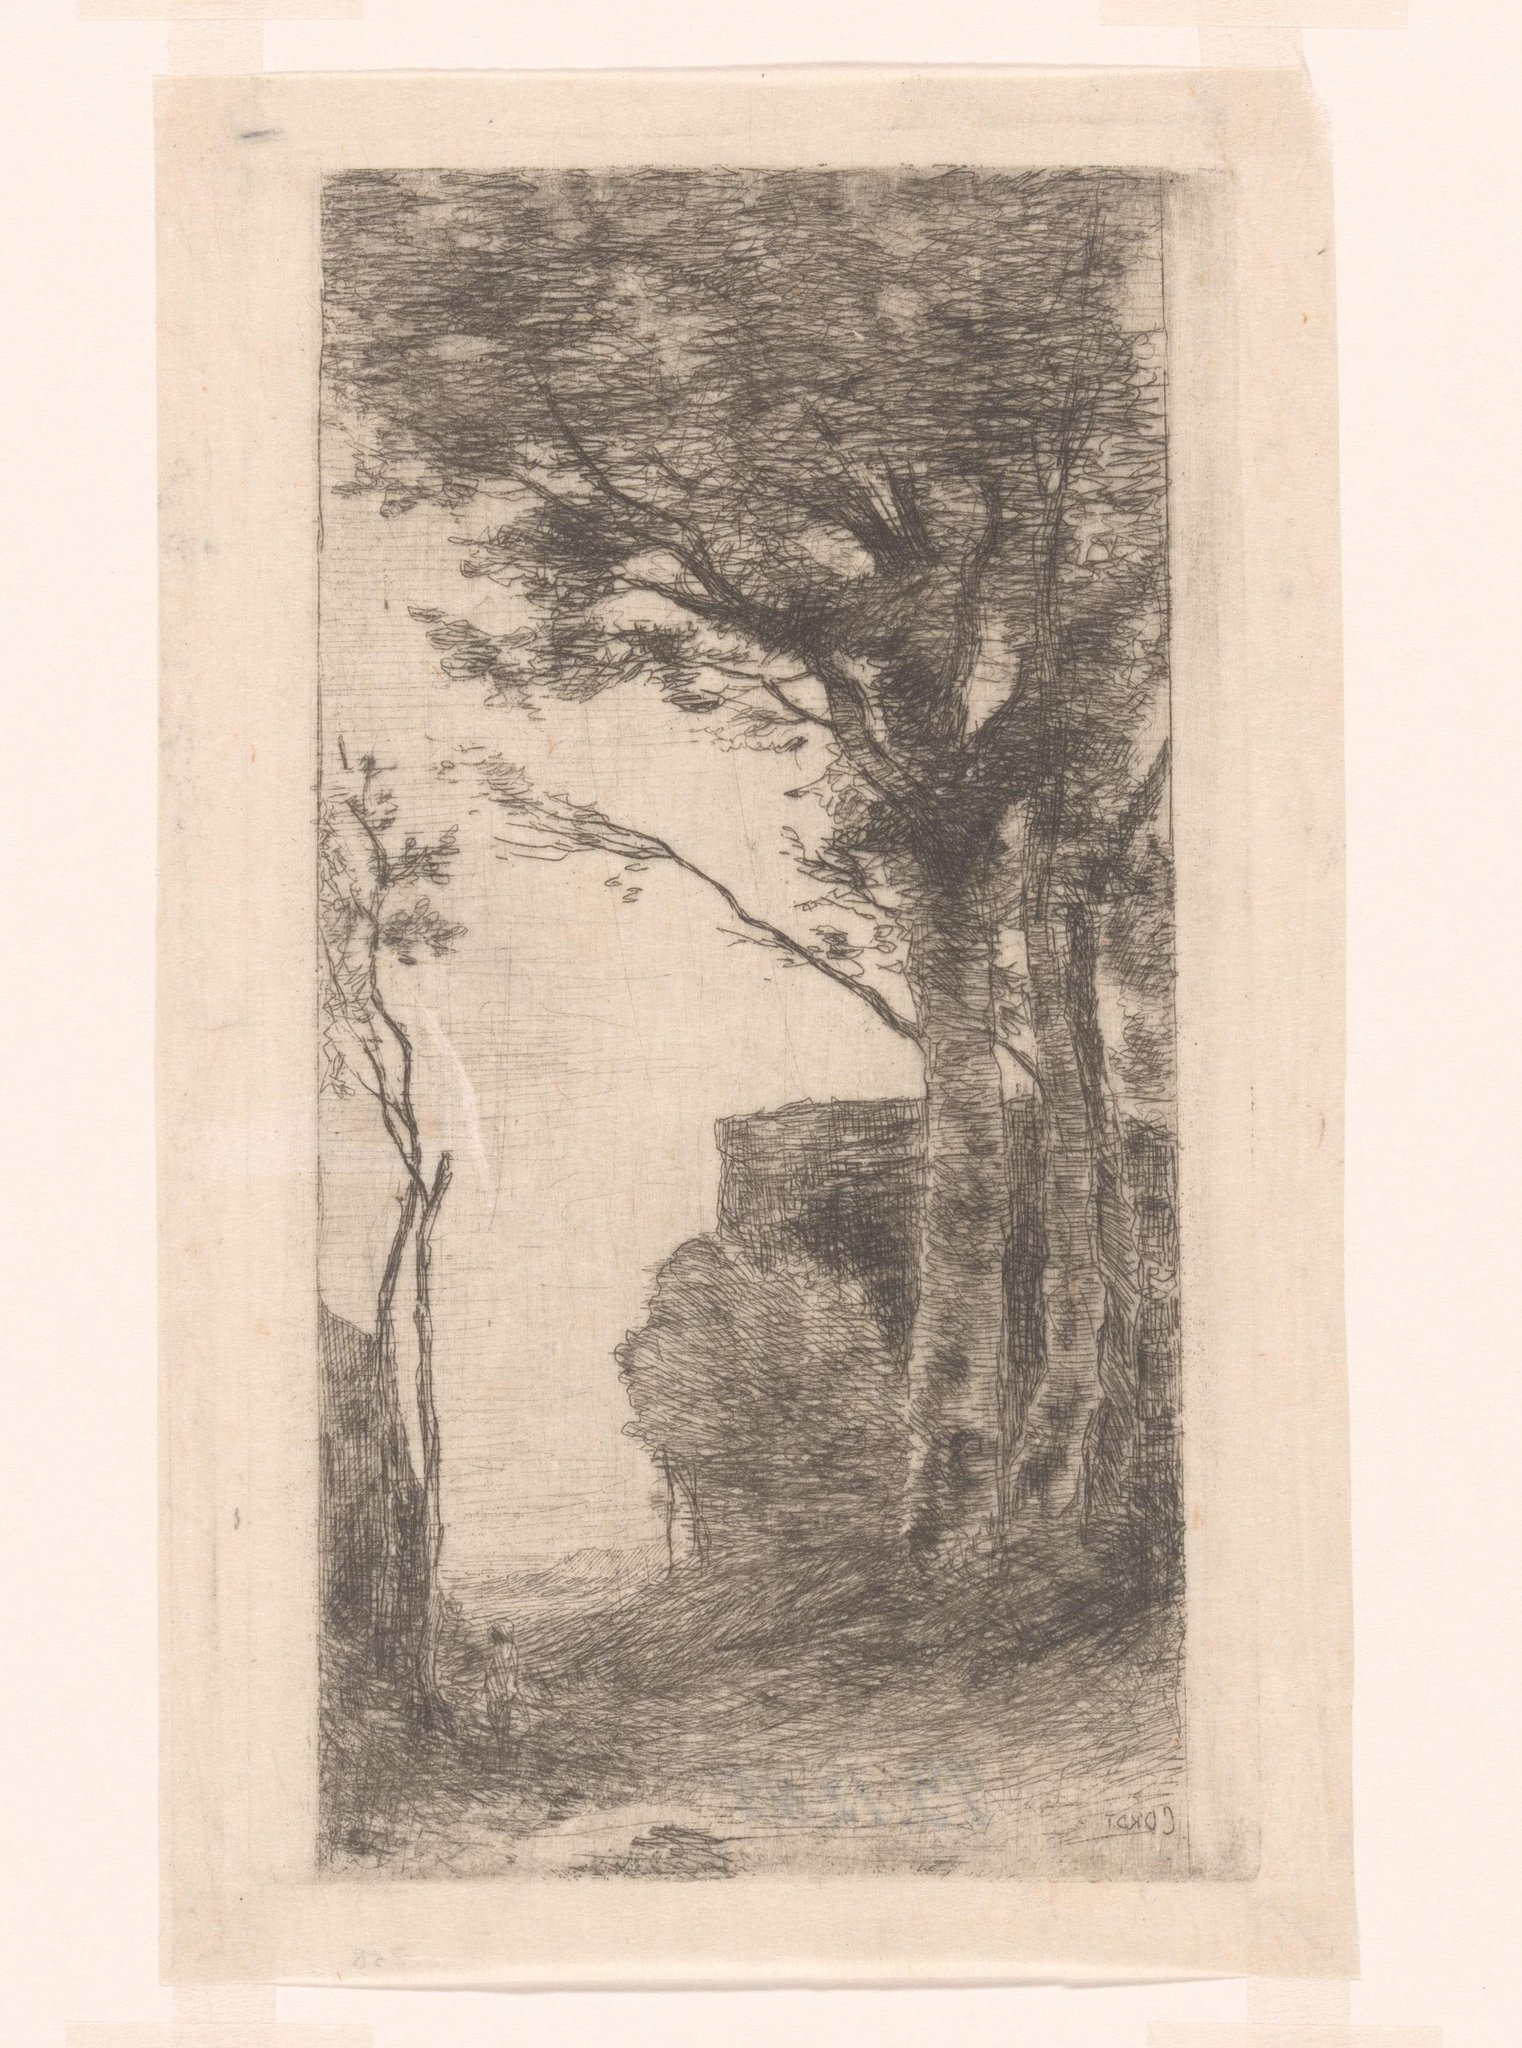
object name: print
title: Landschap met bomen en gebouw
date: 1867-1890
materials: paper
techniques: drypoint, etching, intaglio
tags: landscapes in the temperate zone, civic architecture; edifices; dwellings